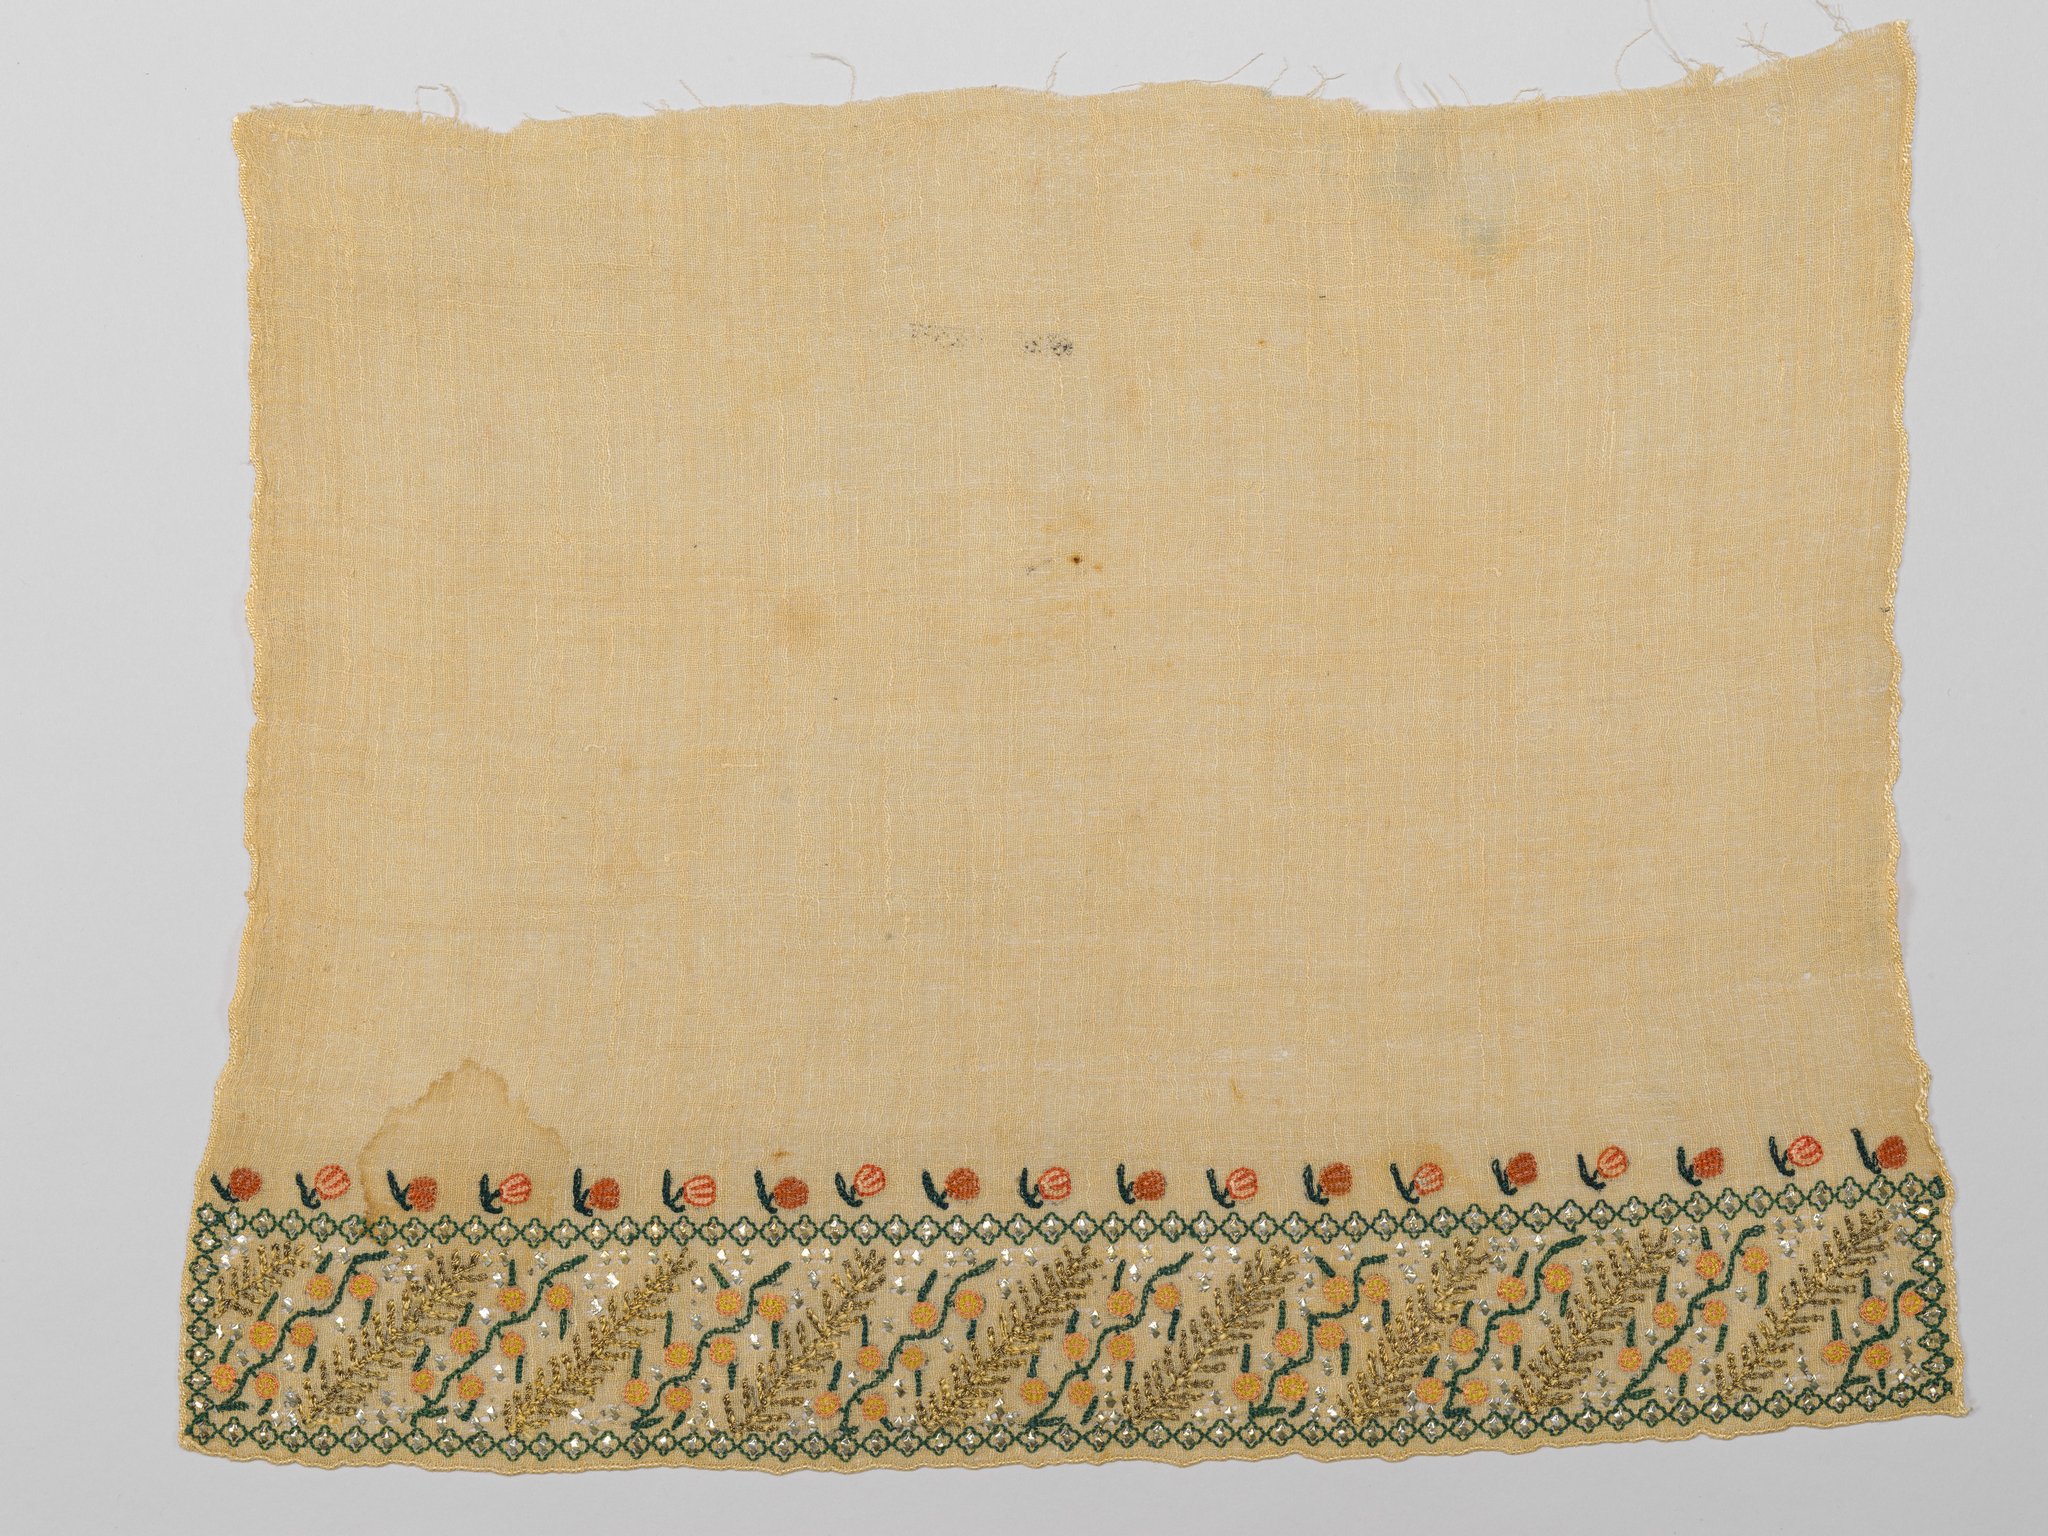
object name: towel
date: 1801-1900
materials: linen, silk, silver gilt, thread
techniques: embroidery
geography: turkey